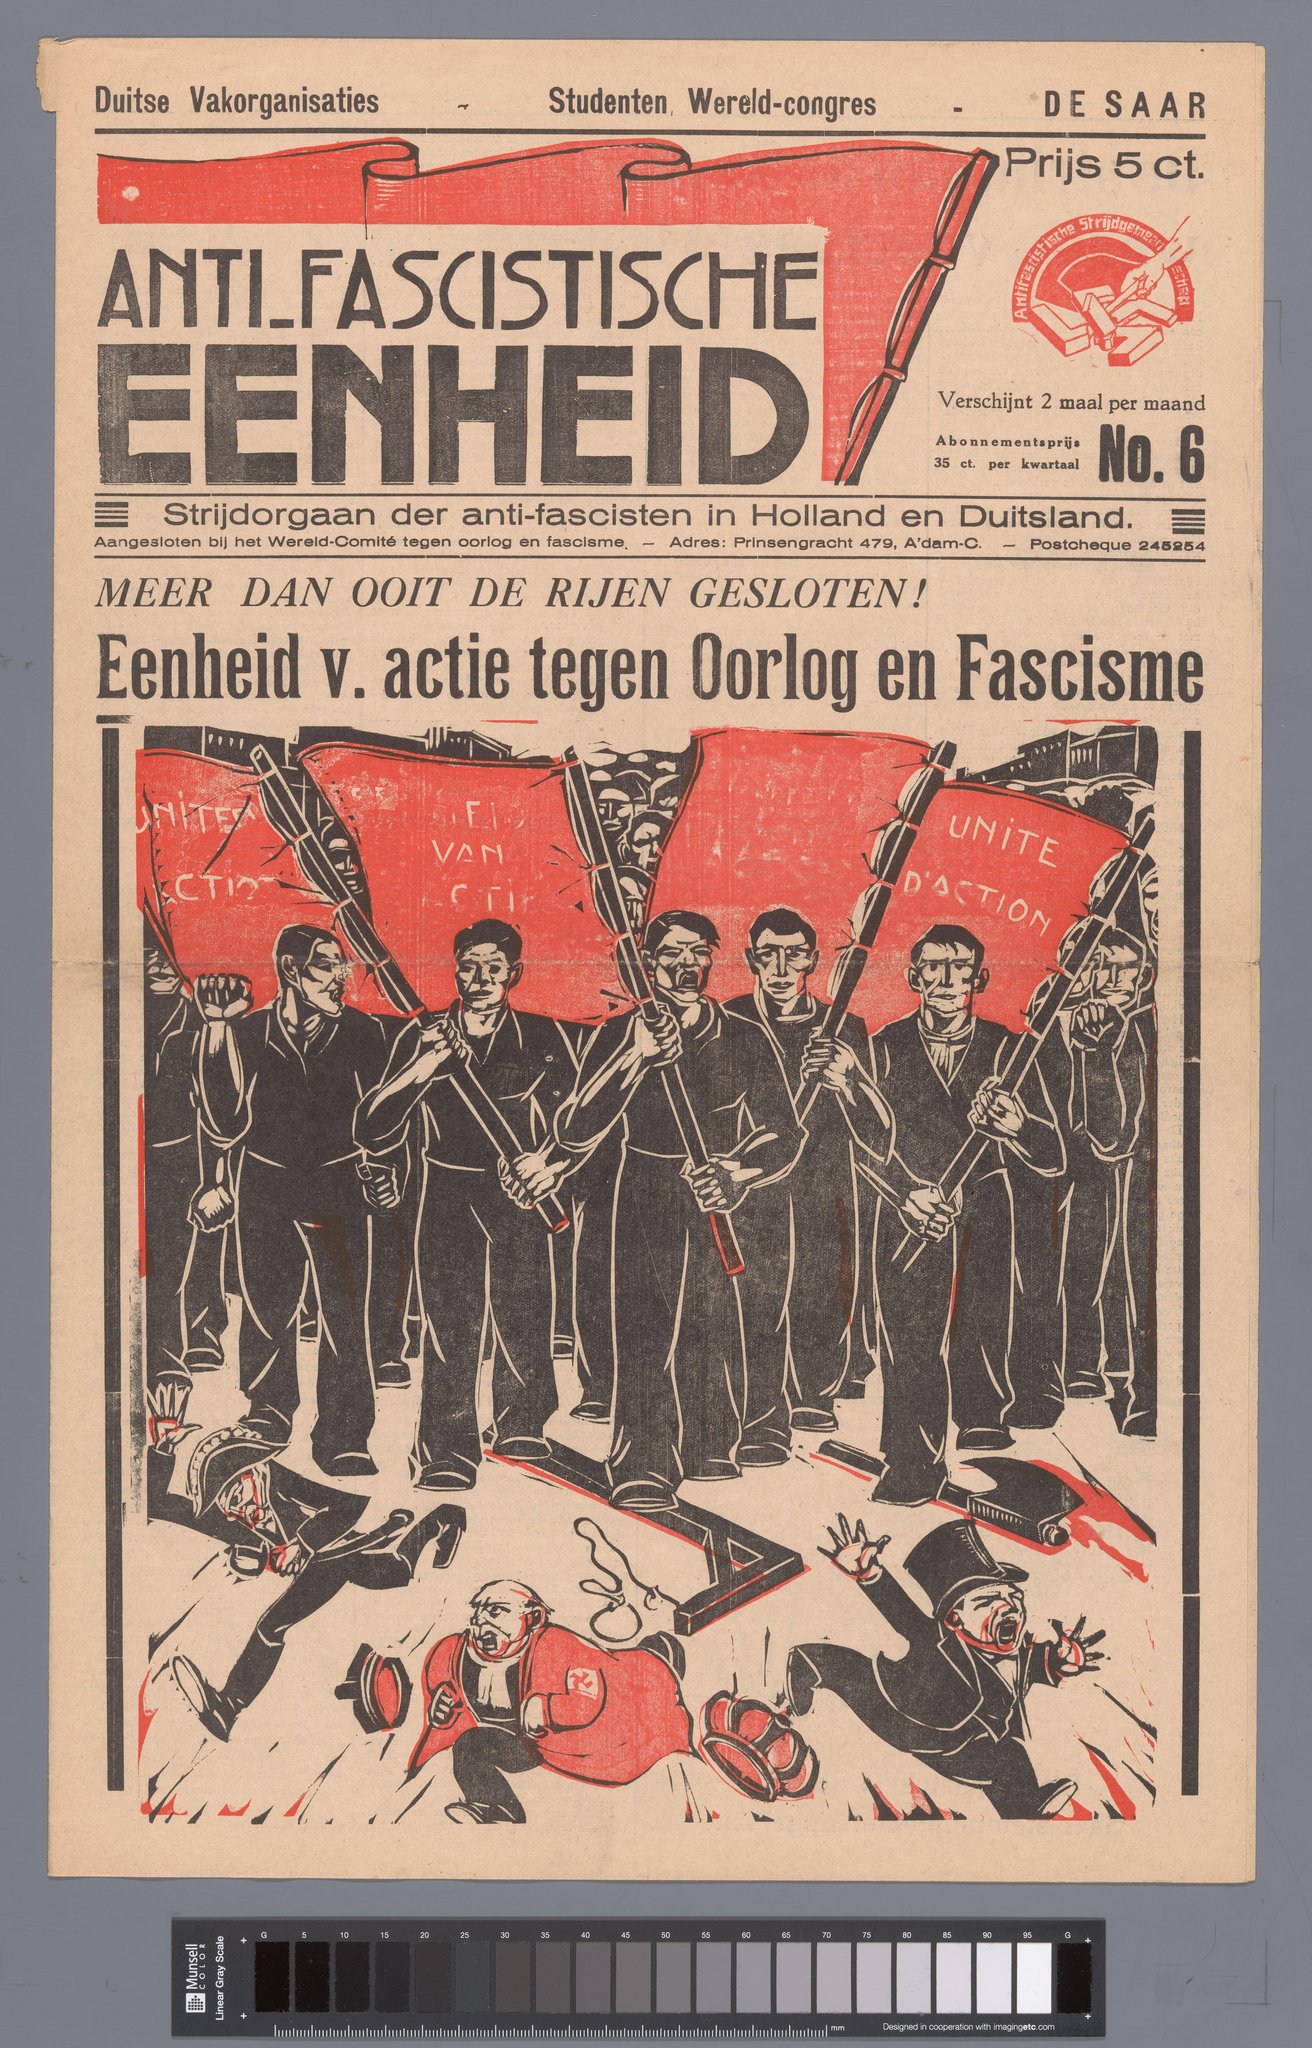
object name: newspaper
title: Anti-fascistische eenheid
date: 1934-1935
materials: paper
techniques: printing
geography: amsterdam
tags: netherlands